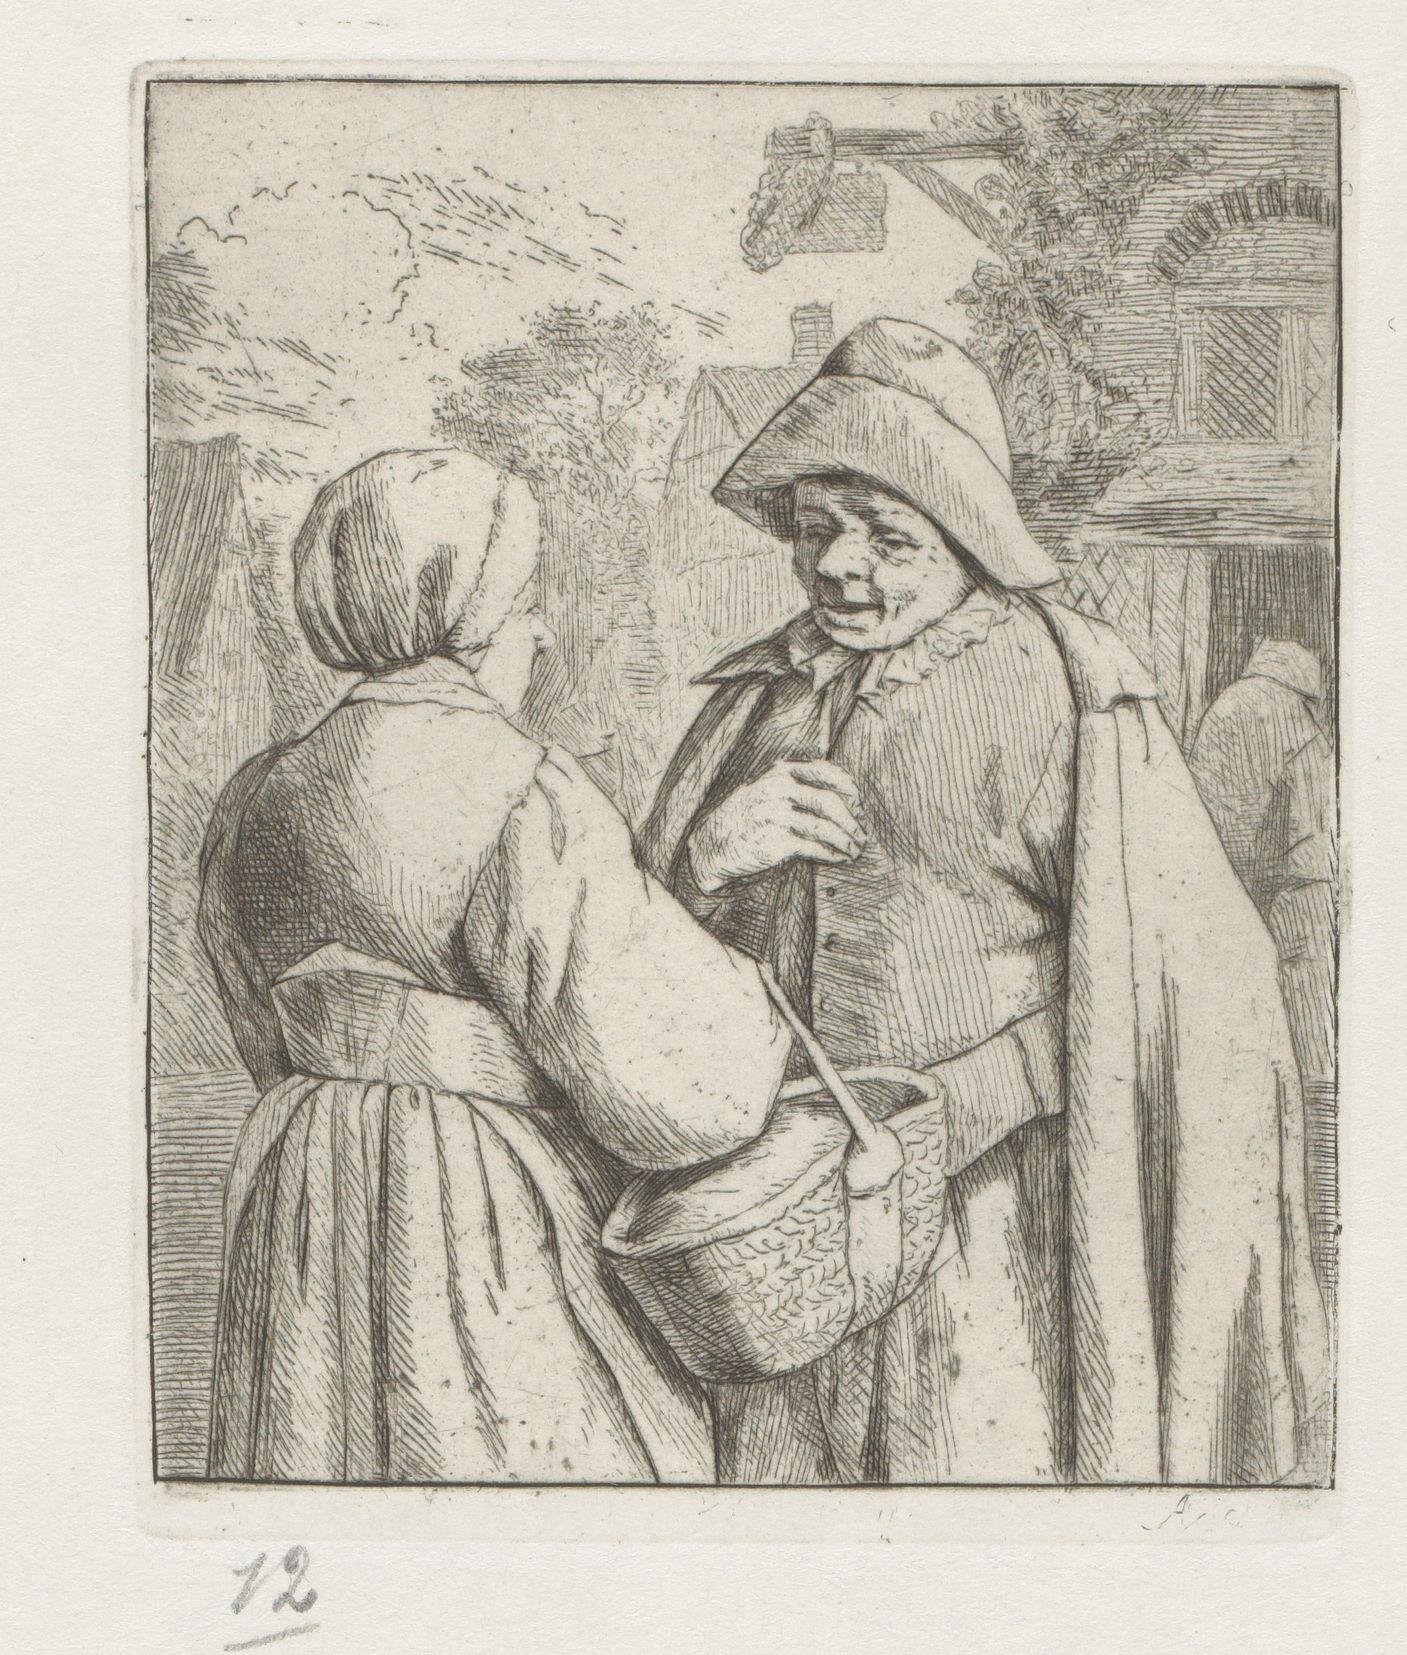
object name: print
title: Vrouw en man met elkaar in gesprek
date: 1668-1678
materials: paper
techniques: etching, galvanization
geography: haarlem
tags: speaking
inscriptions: collector's mark: ‘B’, collector's mark: ‘RIJKS / MUSM’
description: De prent maakt deel uit van een portefeuille en is met een andere prent op één albumblad gedrukt.